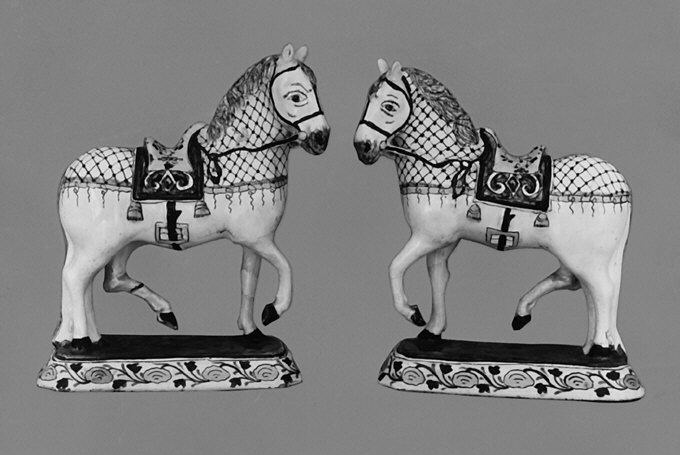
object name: figure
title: Pair of horses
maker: anthoni pennis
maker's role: maker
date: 1750-1775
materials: earthenware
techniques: glazing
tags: horses